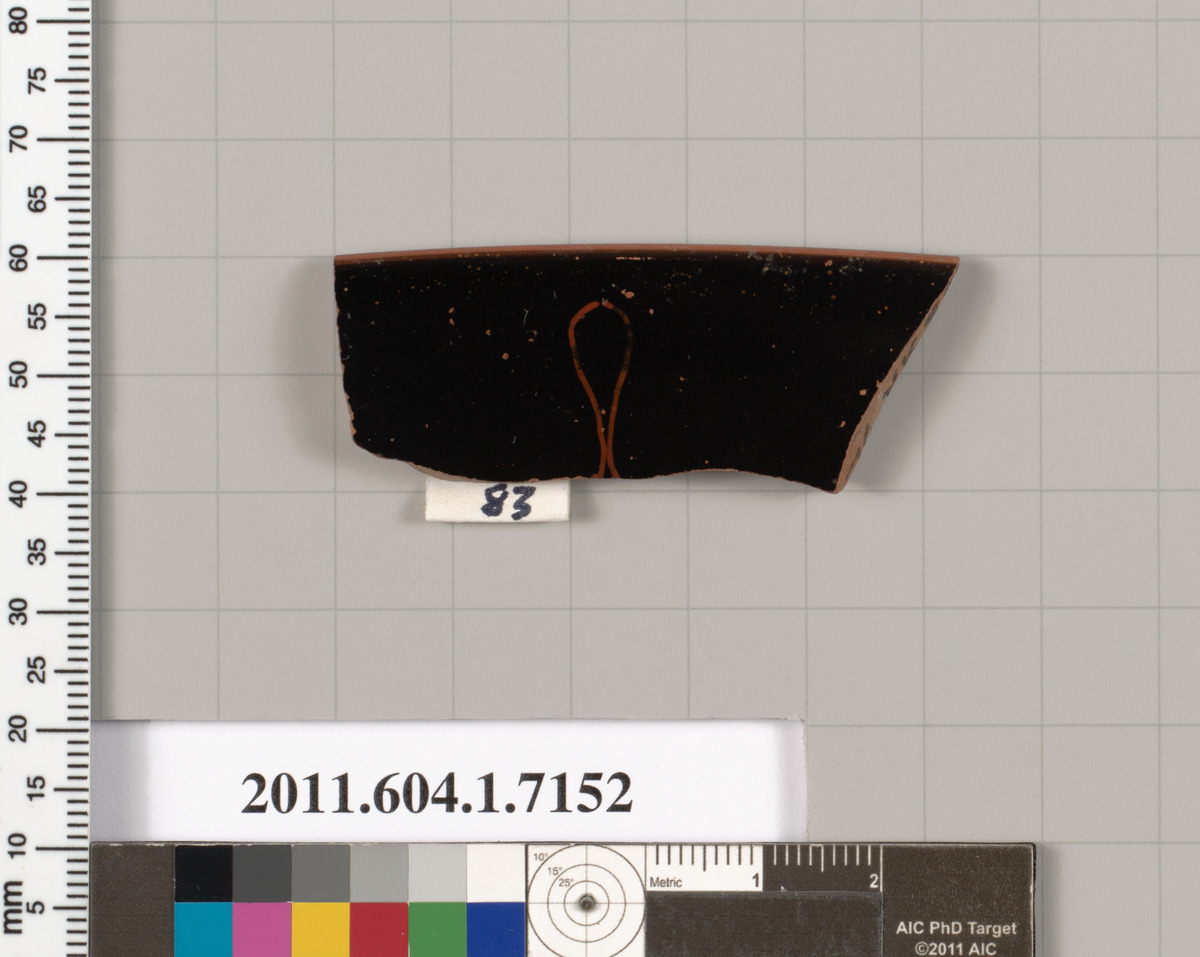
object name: kylix fragment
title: Terracotta rim fragment of a kylix (drinking cup)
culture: greek, attic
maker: makron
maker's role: artist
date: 500-480 BCE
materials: terracotta